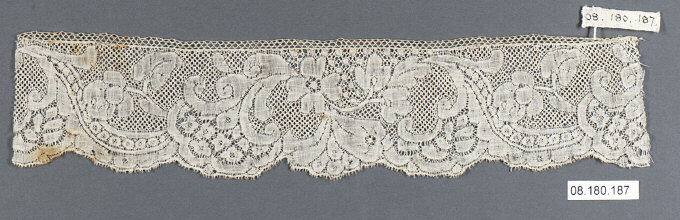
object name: piece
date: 1701-1800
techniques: lace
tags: flowers,leaves